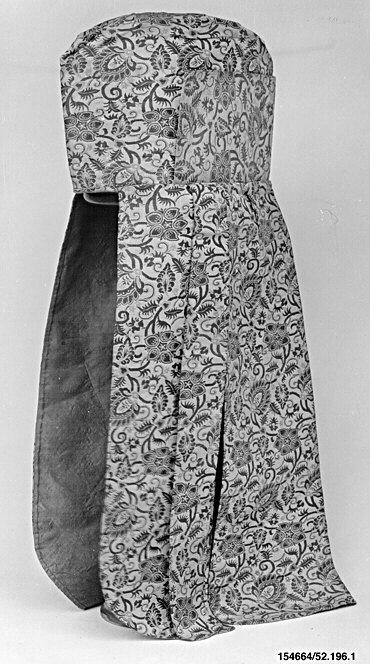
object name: hat, buddhist abbot's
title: Buddhist Abbot's Hat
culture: japanese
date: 1801-1900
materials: textile, silk